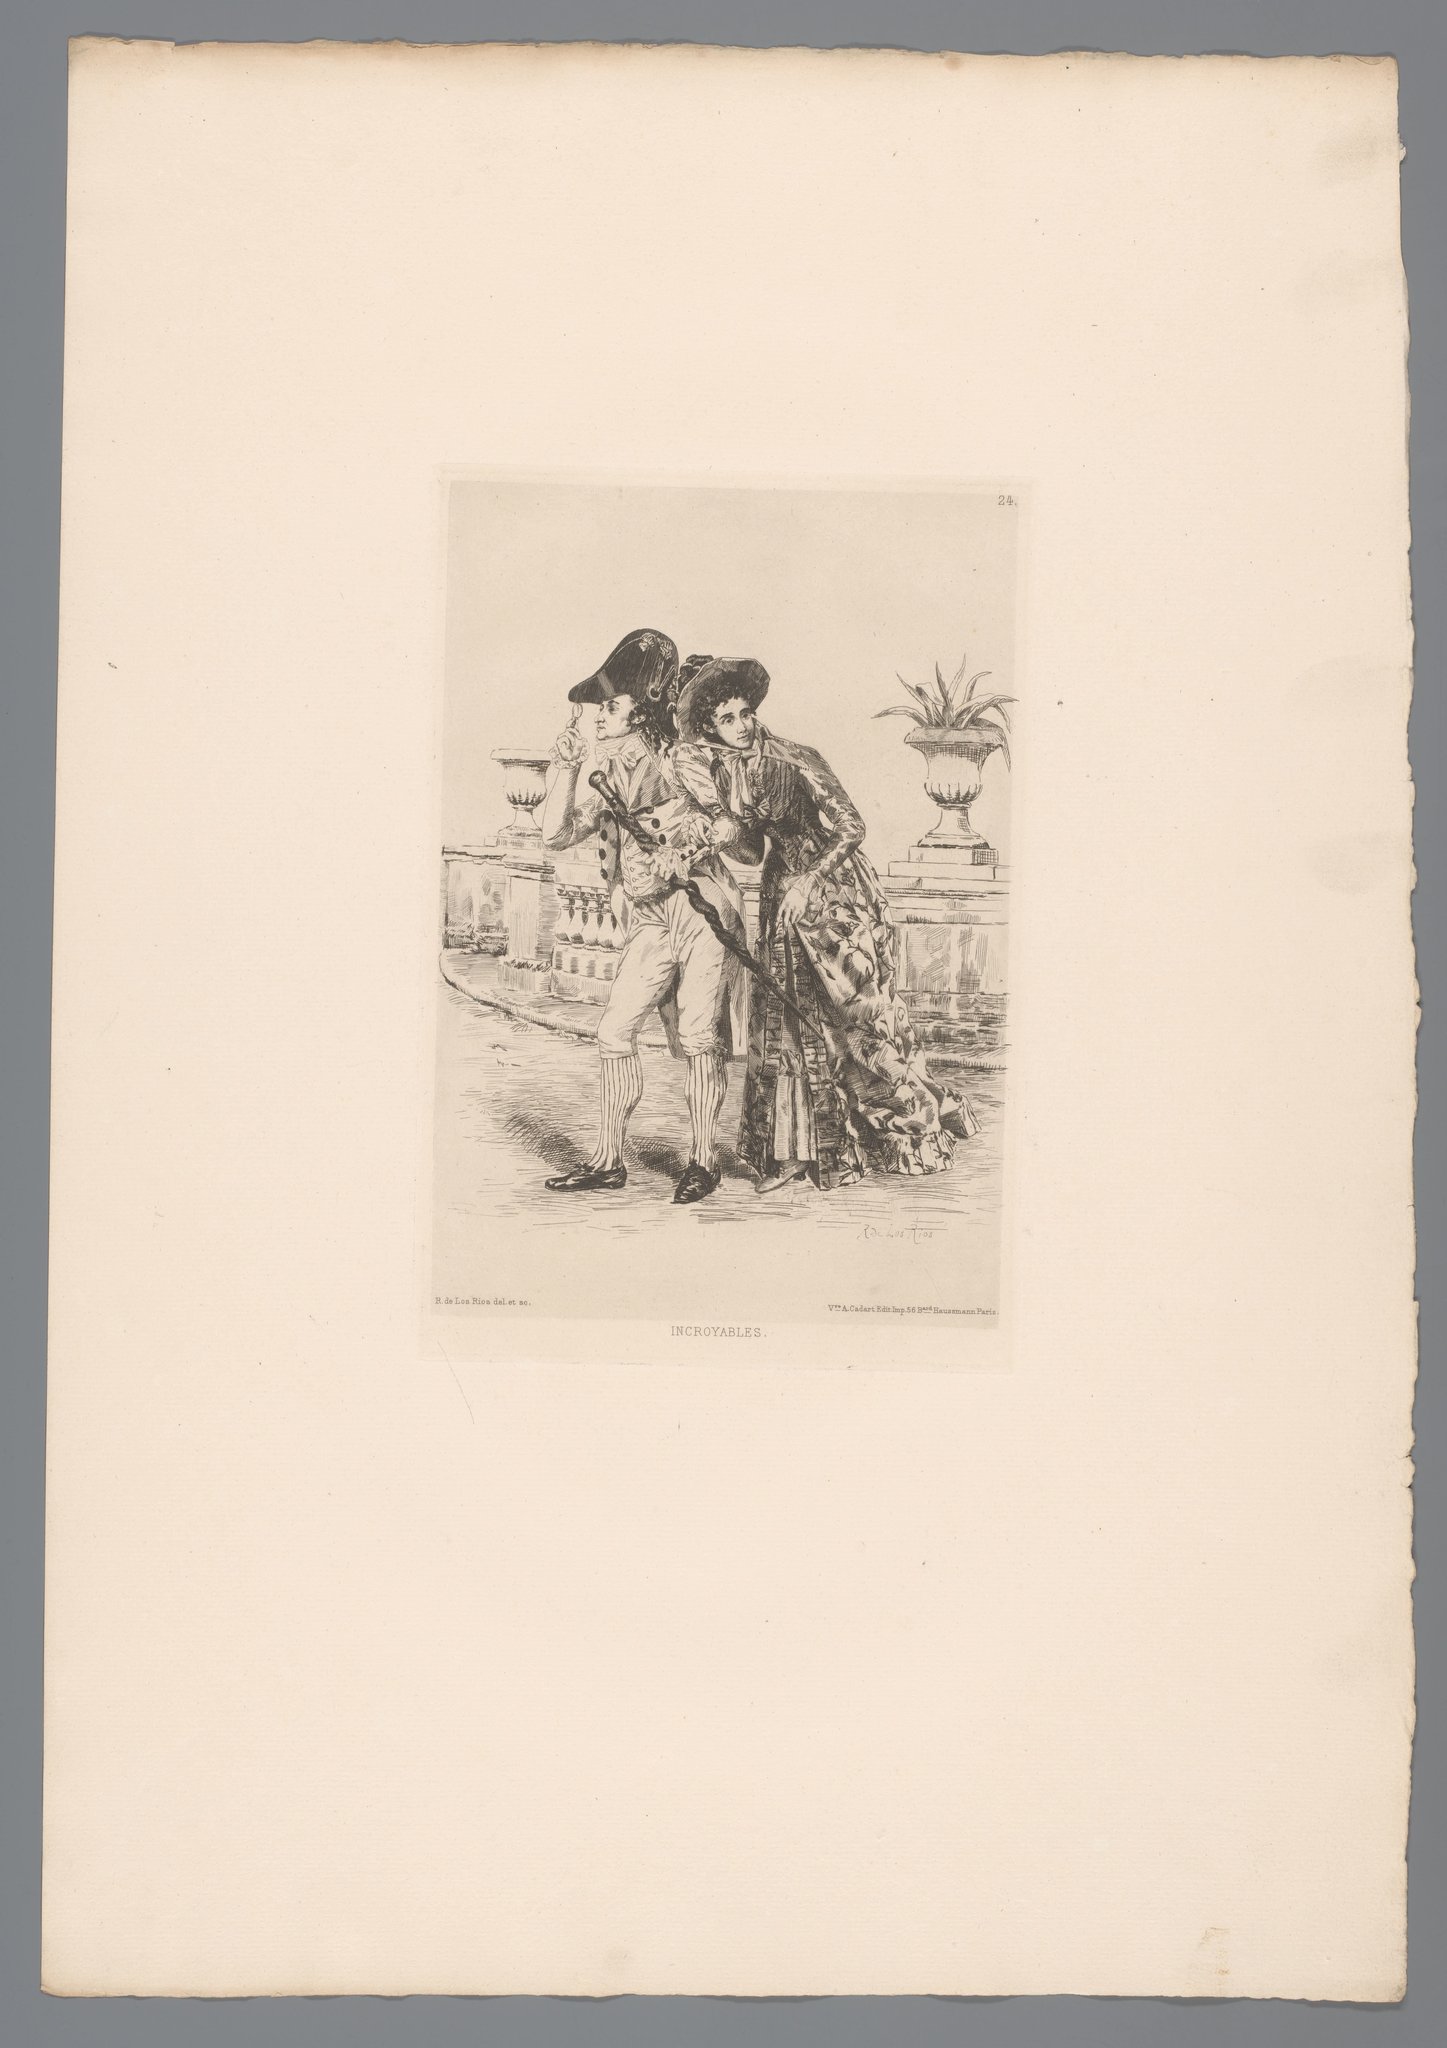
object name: print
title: Incroyables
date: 1878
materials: paper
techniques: drypoint, etching, intaglio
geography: paris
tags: terrace, arm in arm (lovers)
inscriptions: collector's mark: Lugt 2228, collector's mark: Lugt 2760, collector's mark: ‘AFE v S’, watermark